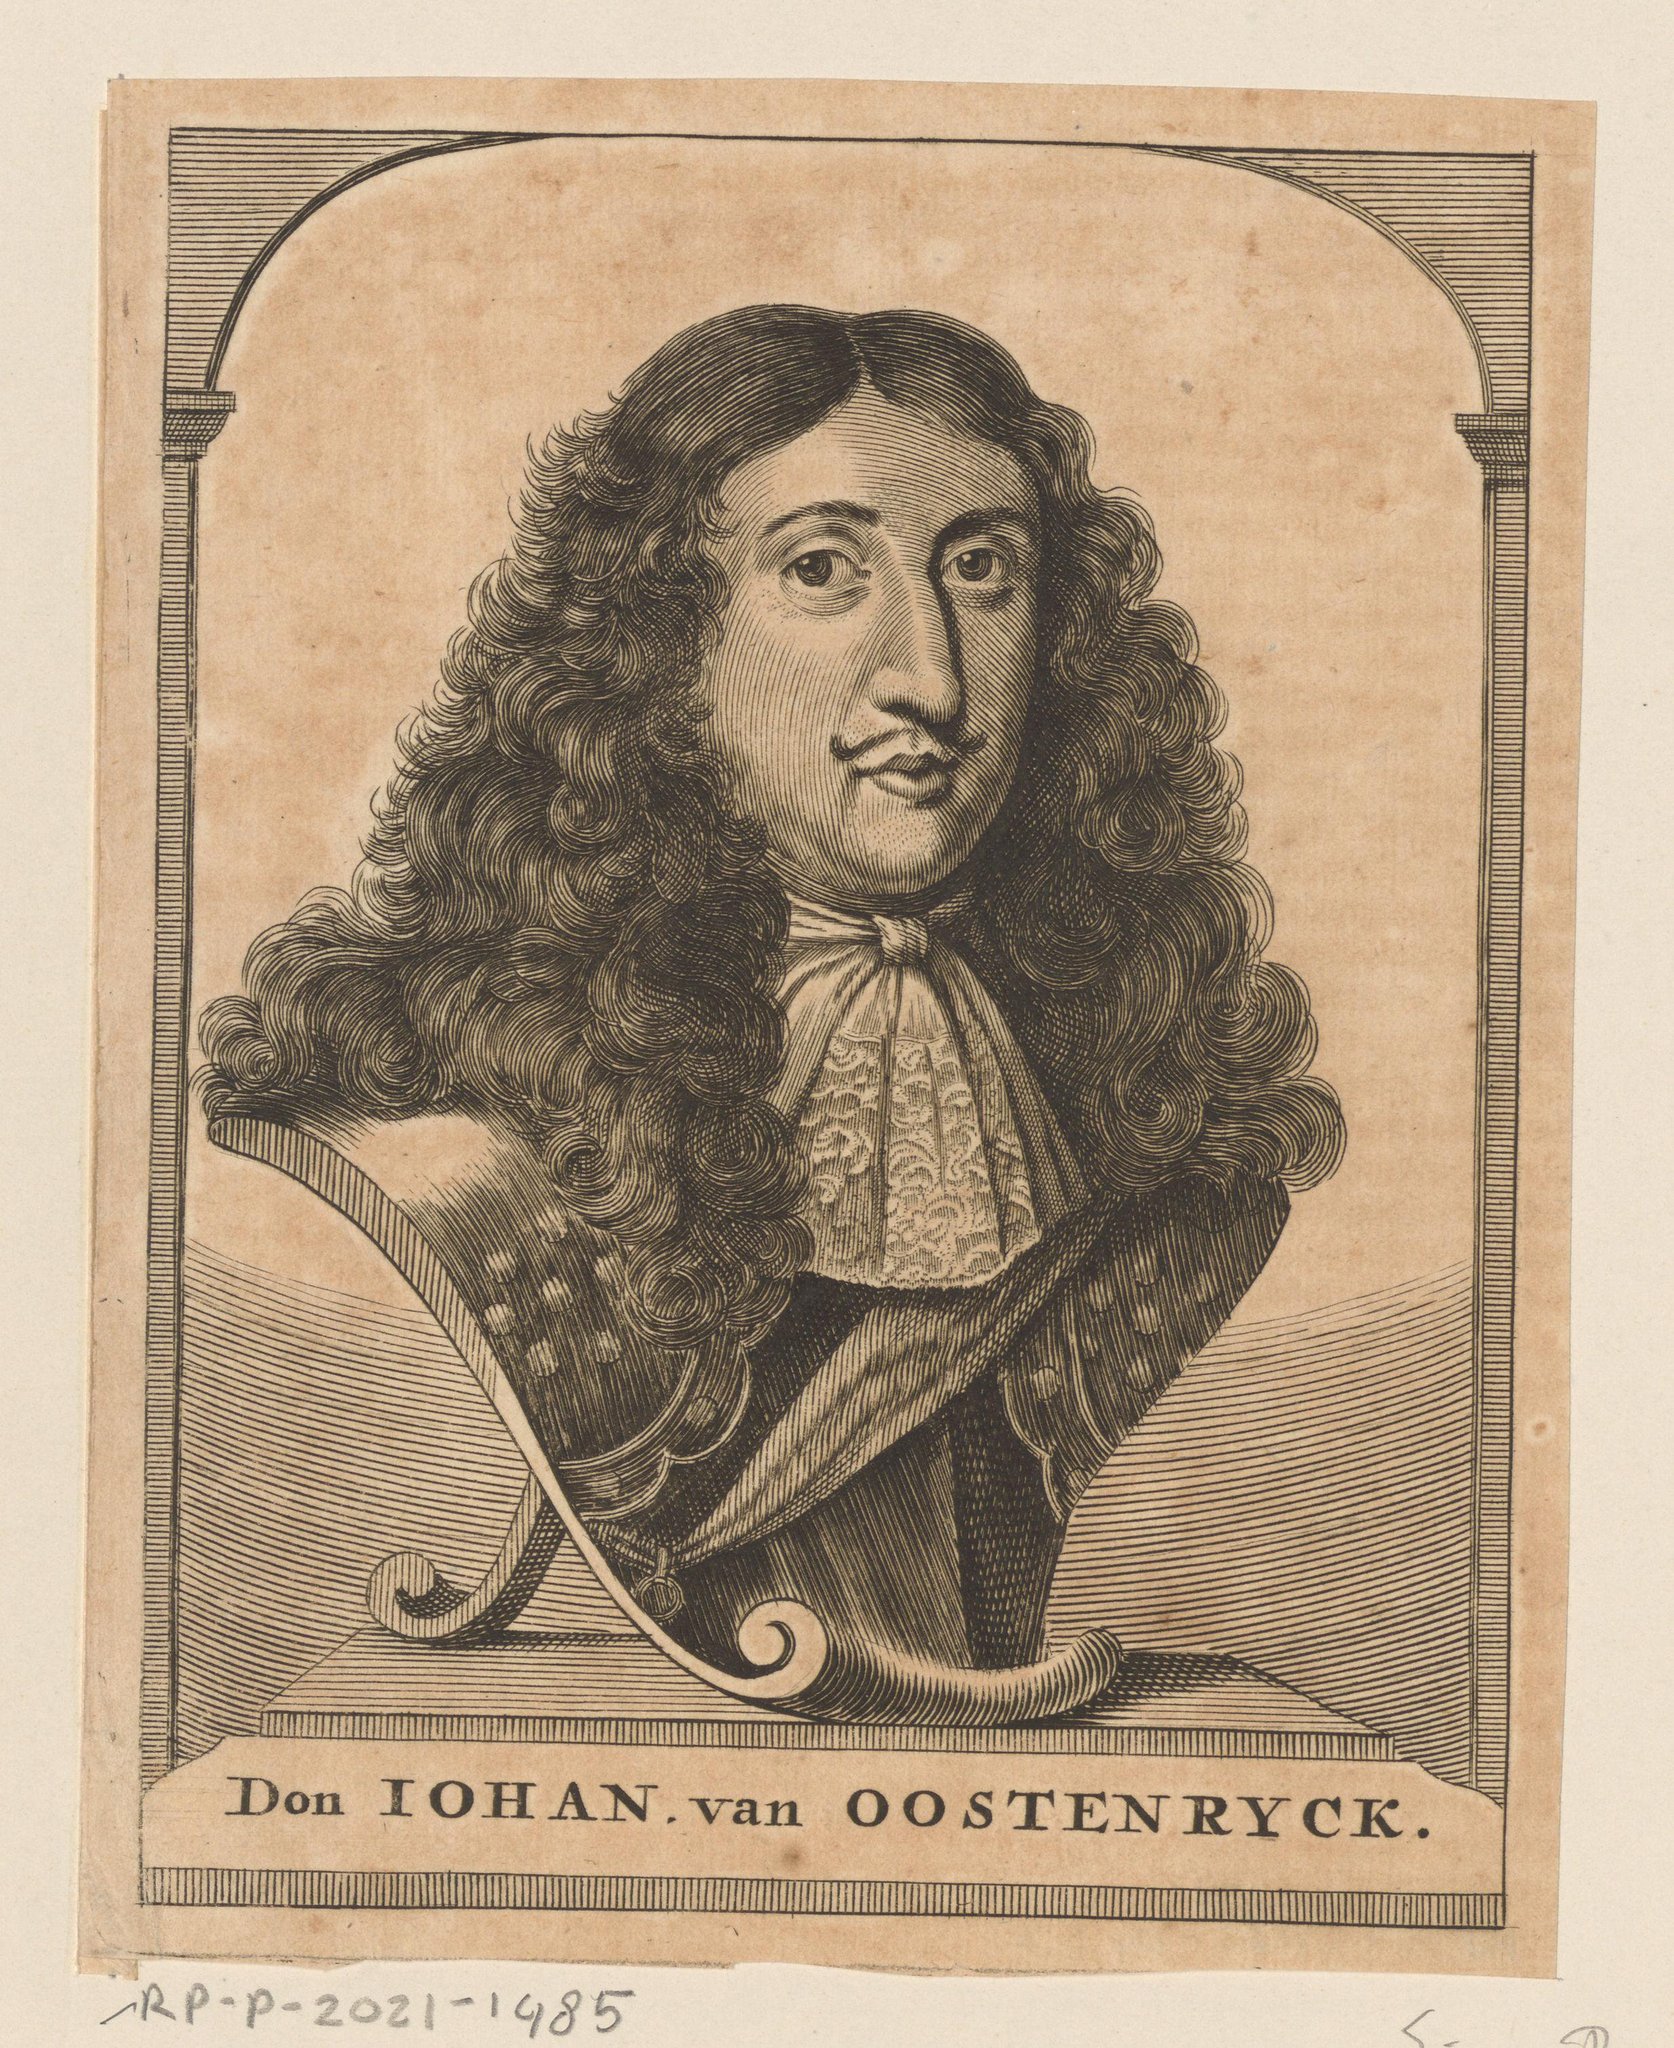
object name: print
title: Portret van Don Juan II van Oostenrijk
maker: Anonymous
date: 1678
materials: paper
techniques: engraving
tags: historical persons, ruler, sovereign, armorial bearing, heraldry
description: Prent mogelijk uit: Brandt, Geeraert II. Tweejaerige geschiedenissen, voorgevallen in de jaeren MDCLXXIV. Amsterdam: Johannes van Someren, Abraham Wolfgangh, Hendrik en Dirk Boom, 1678.